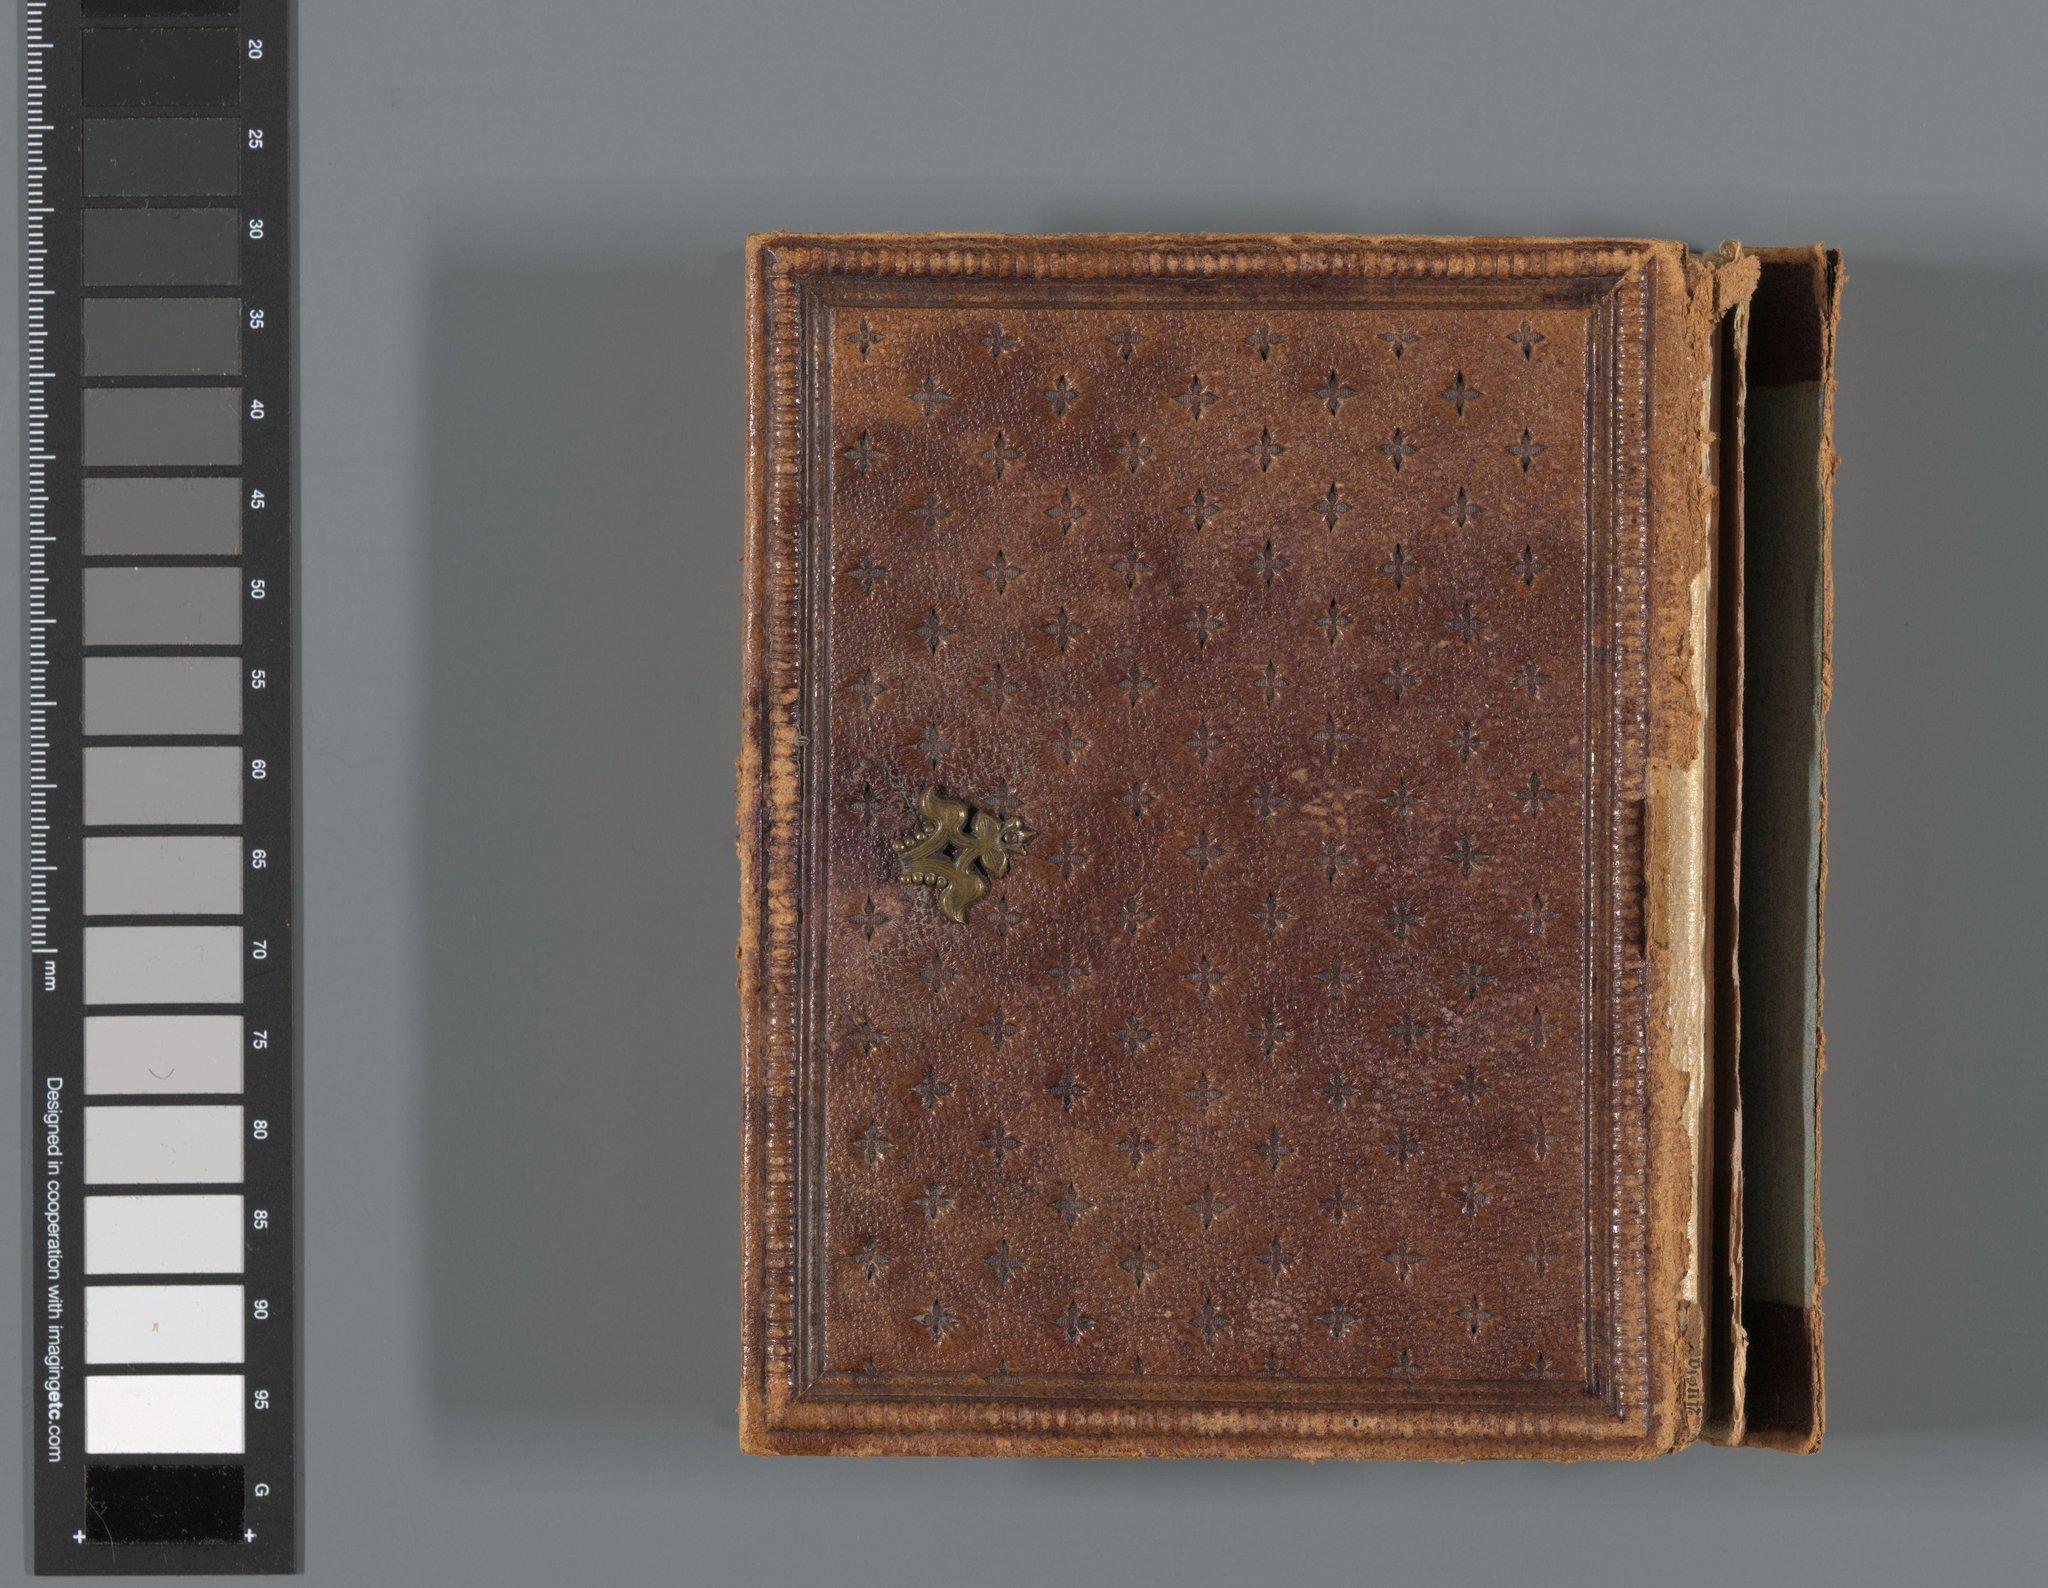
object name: photograph album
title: Leeg album voor cartes-de-visite van de familie Van den Berg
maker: Anonymous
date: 1860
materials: cardboard, leather, metal, paper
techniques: moire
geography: netherlands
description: Insteekalbum voor cartes-de-visite. Het album is leeg, maar bevat wel handgeschreven bijschriften van de foto's die erin zaten.